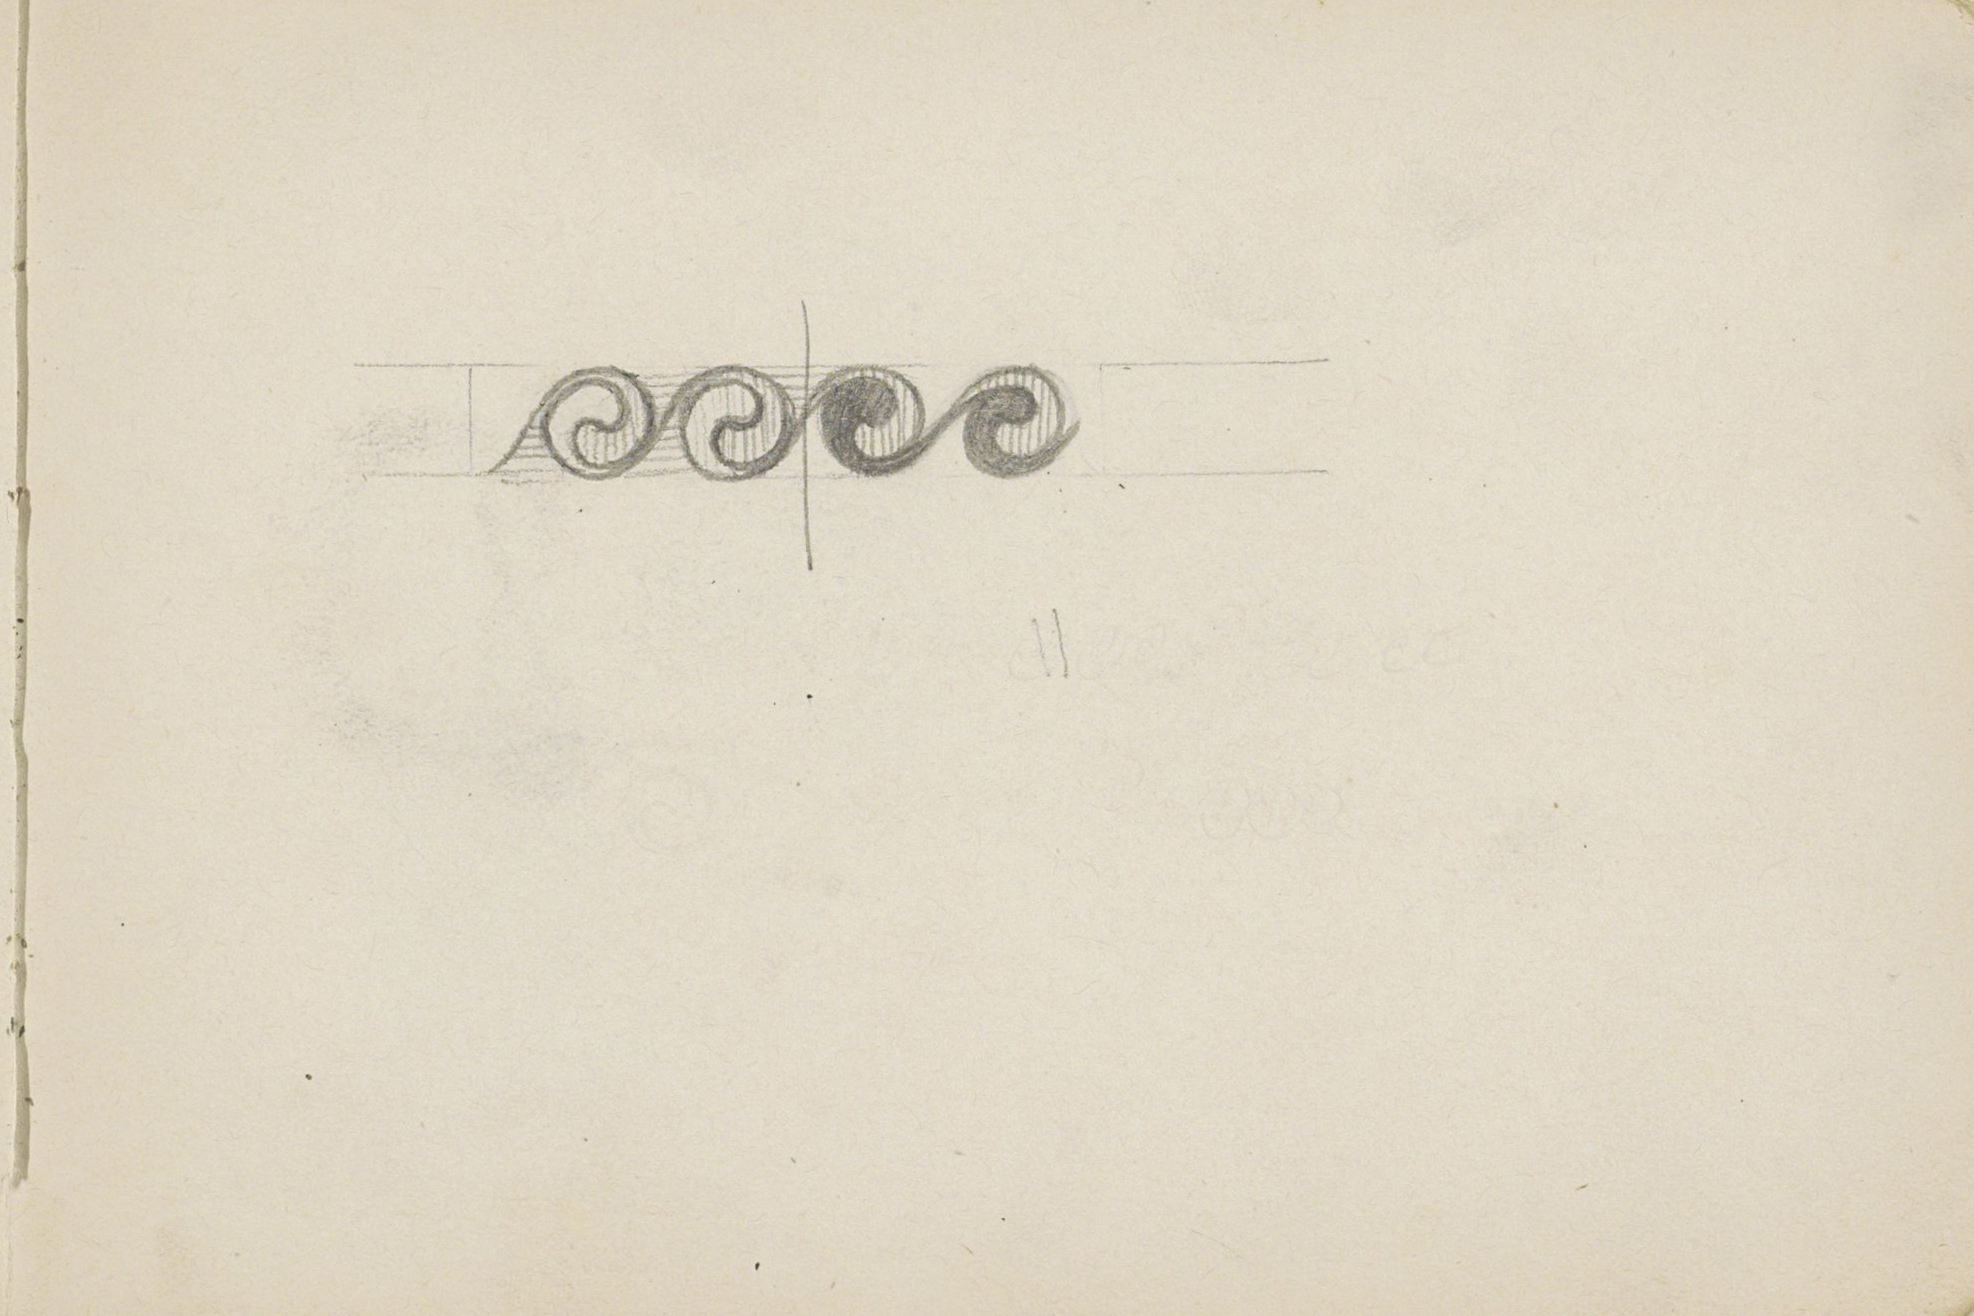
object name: sketchbook leaf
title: Ornamenteel krulpatroon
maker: julie de graag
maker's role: draughtsman, print maker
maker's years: 1877-1924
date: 1894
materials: paper, pencil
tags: ribbon, scroll, banderole ~ ornament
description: Blad 30 recto uit een schetsboek met 35 bladen.